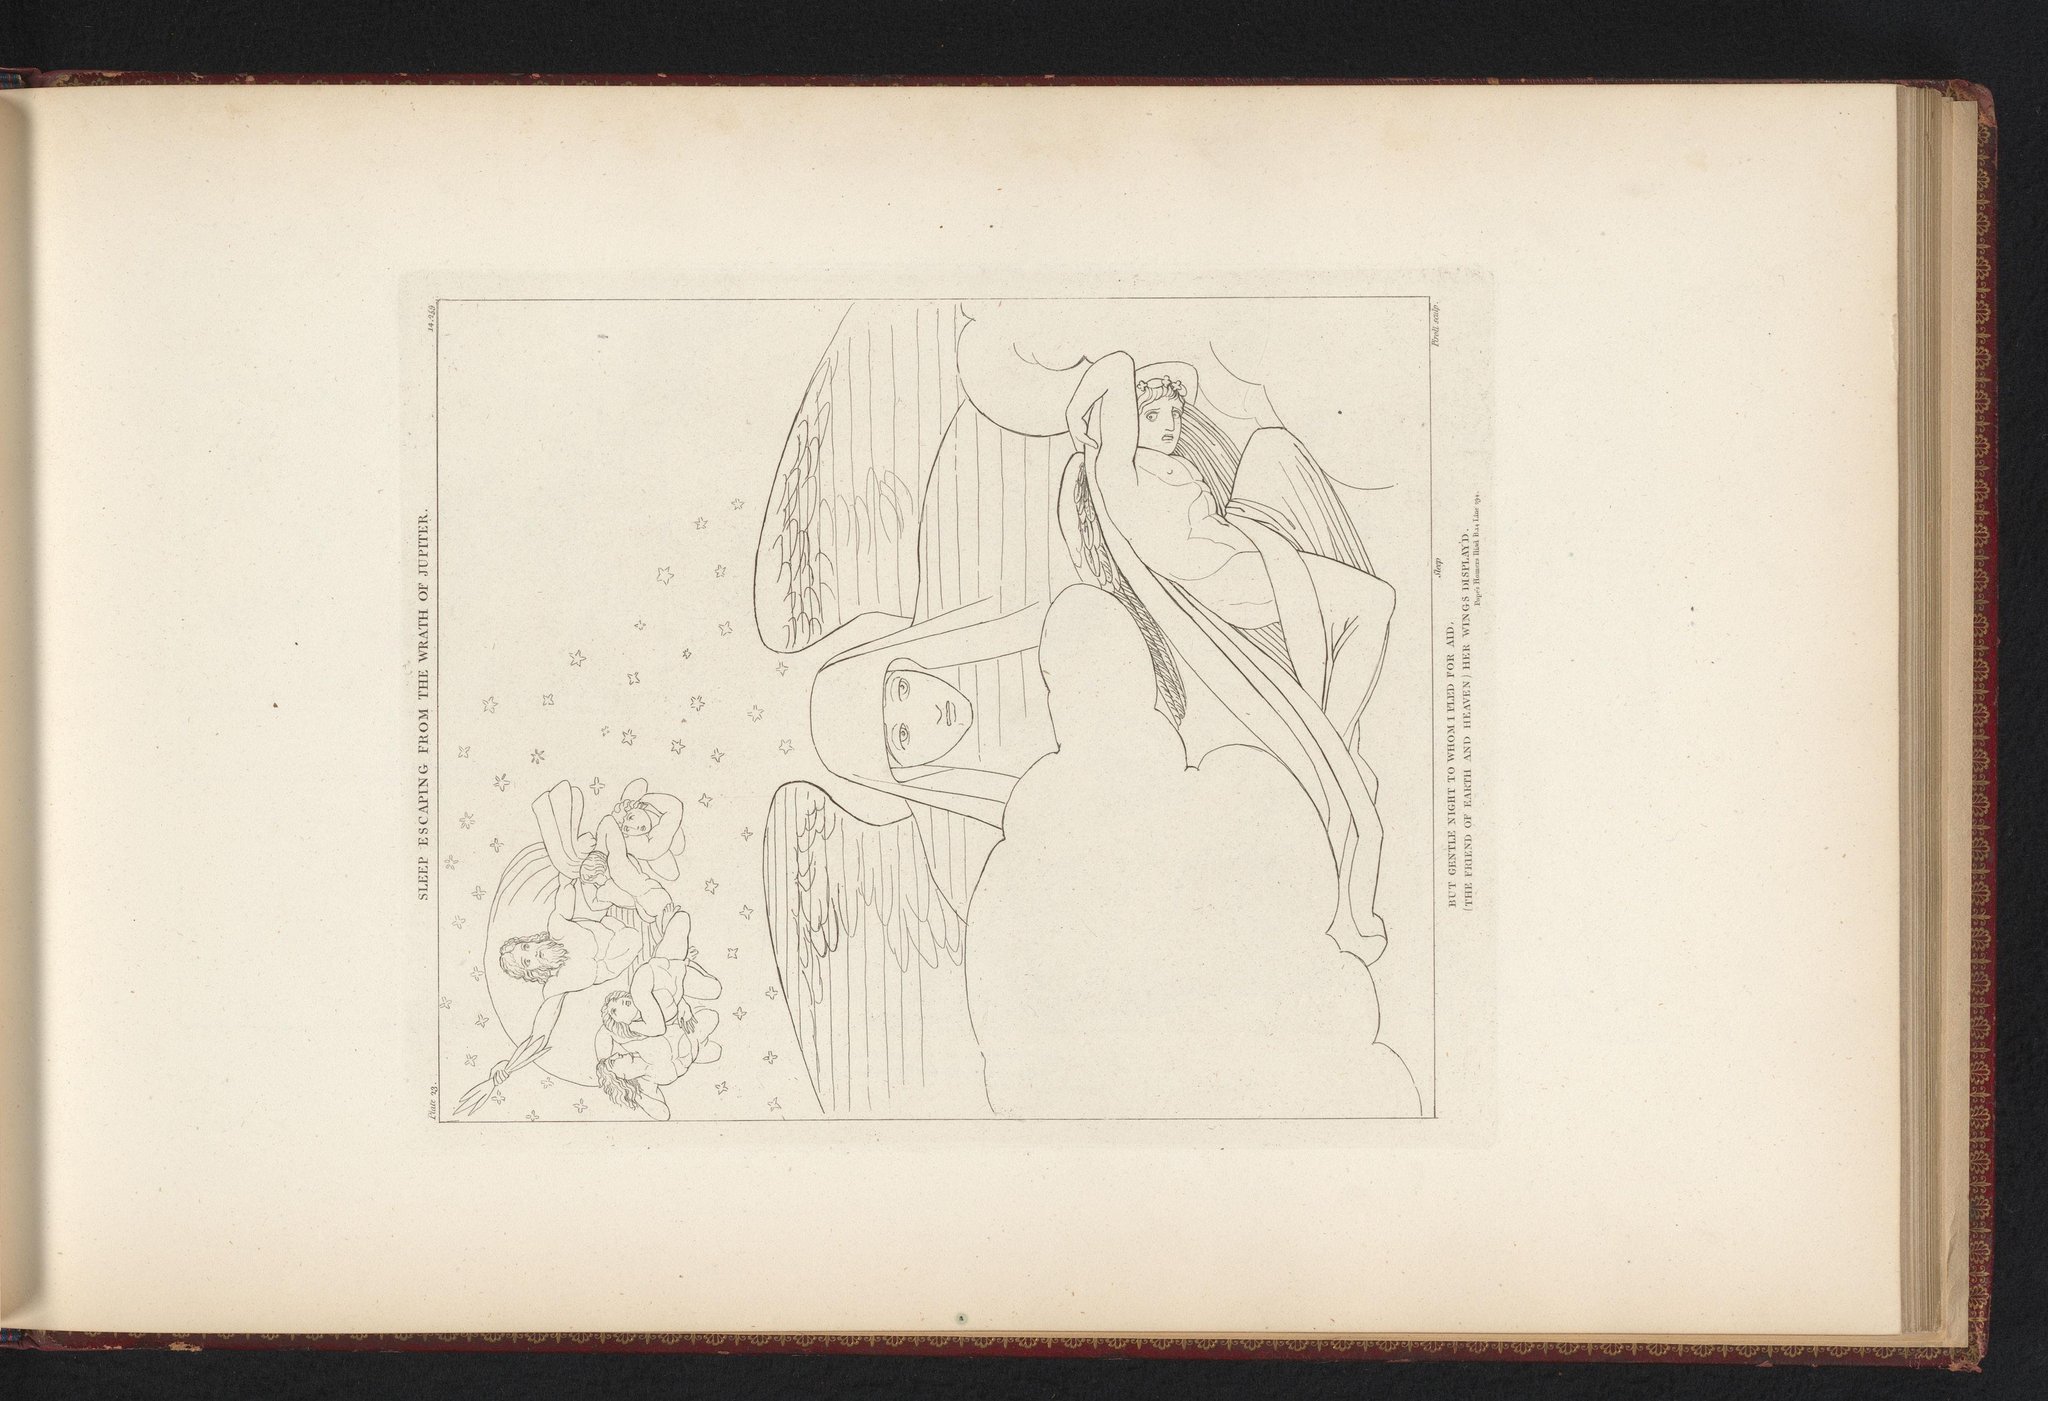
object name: print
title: Sleep escaping from the wrath of Jupiter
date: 1805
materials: paper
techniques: etching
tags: (story of) hypnos (somnus), sleep, (story of) jupiter (zeus)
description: Prent maakt onderdeel uit van een serie met 39 prenten over de Ilias, geschreven door Homerus.